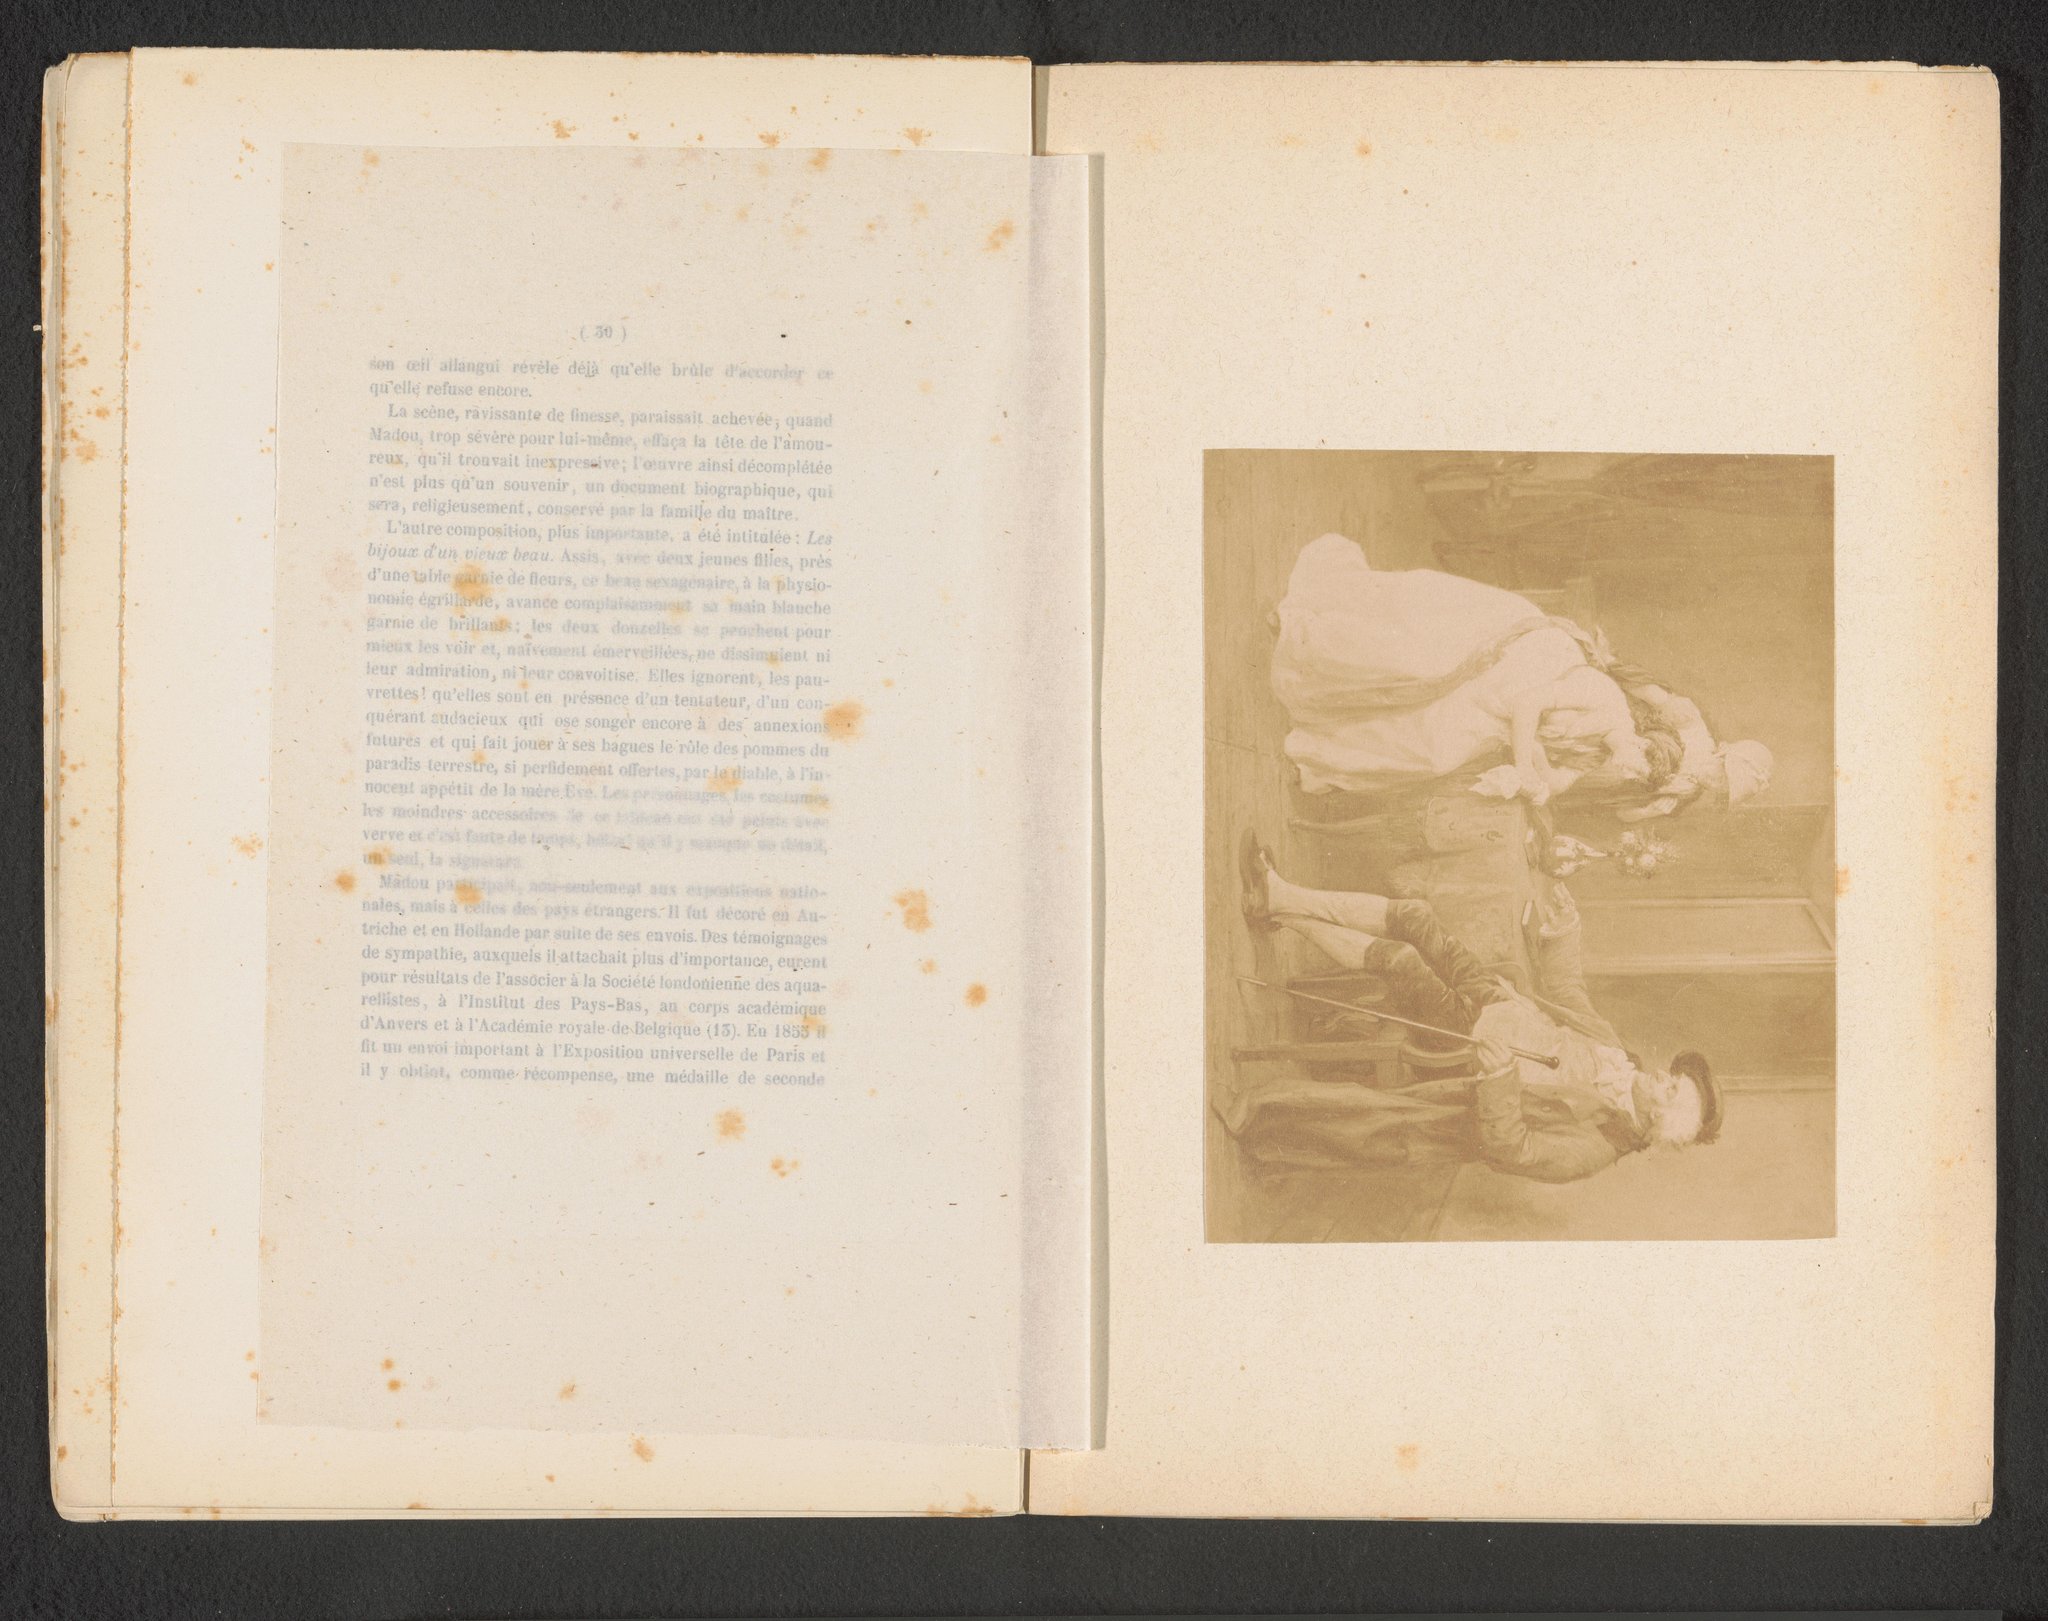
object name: photograph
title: Fotoreproductie van een werk van een onbekende man en een onbekende vrouw aan een tafel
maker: Anonymous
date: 1874-1879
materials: photographic support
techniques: albumen print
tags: adult woman, adult man, table